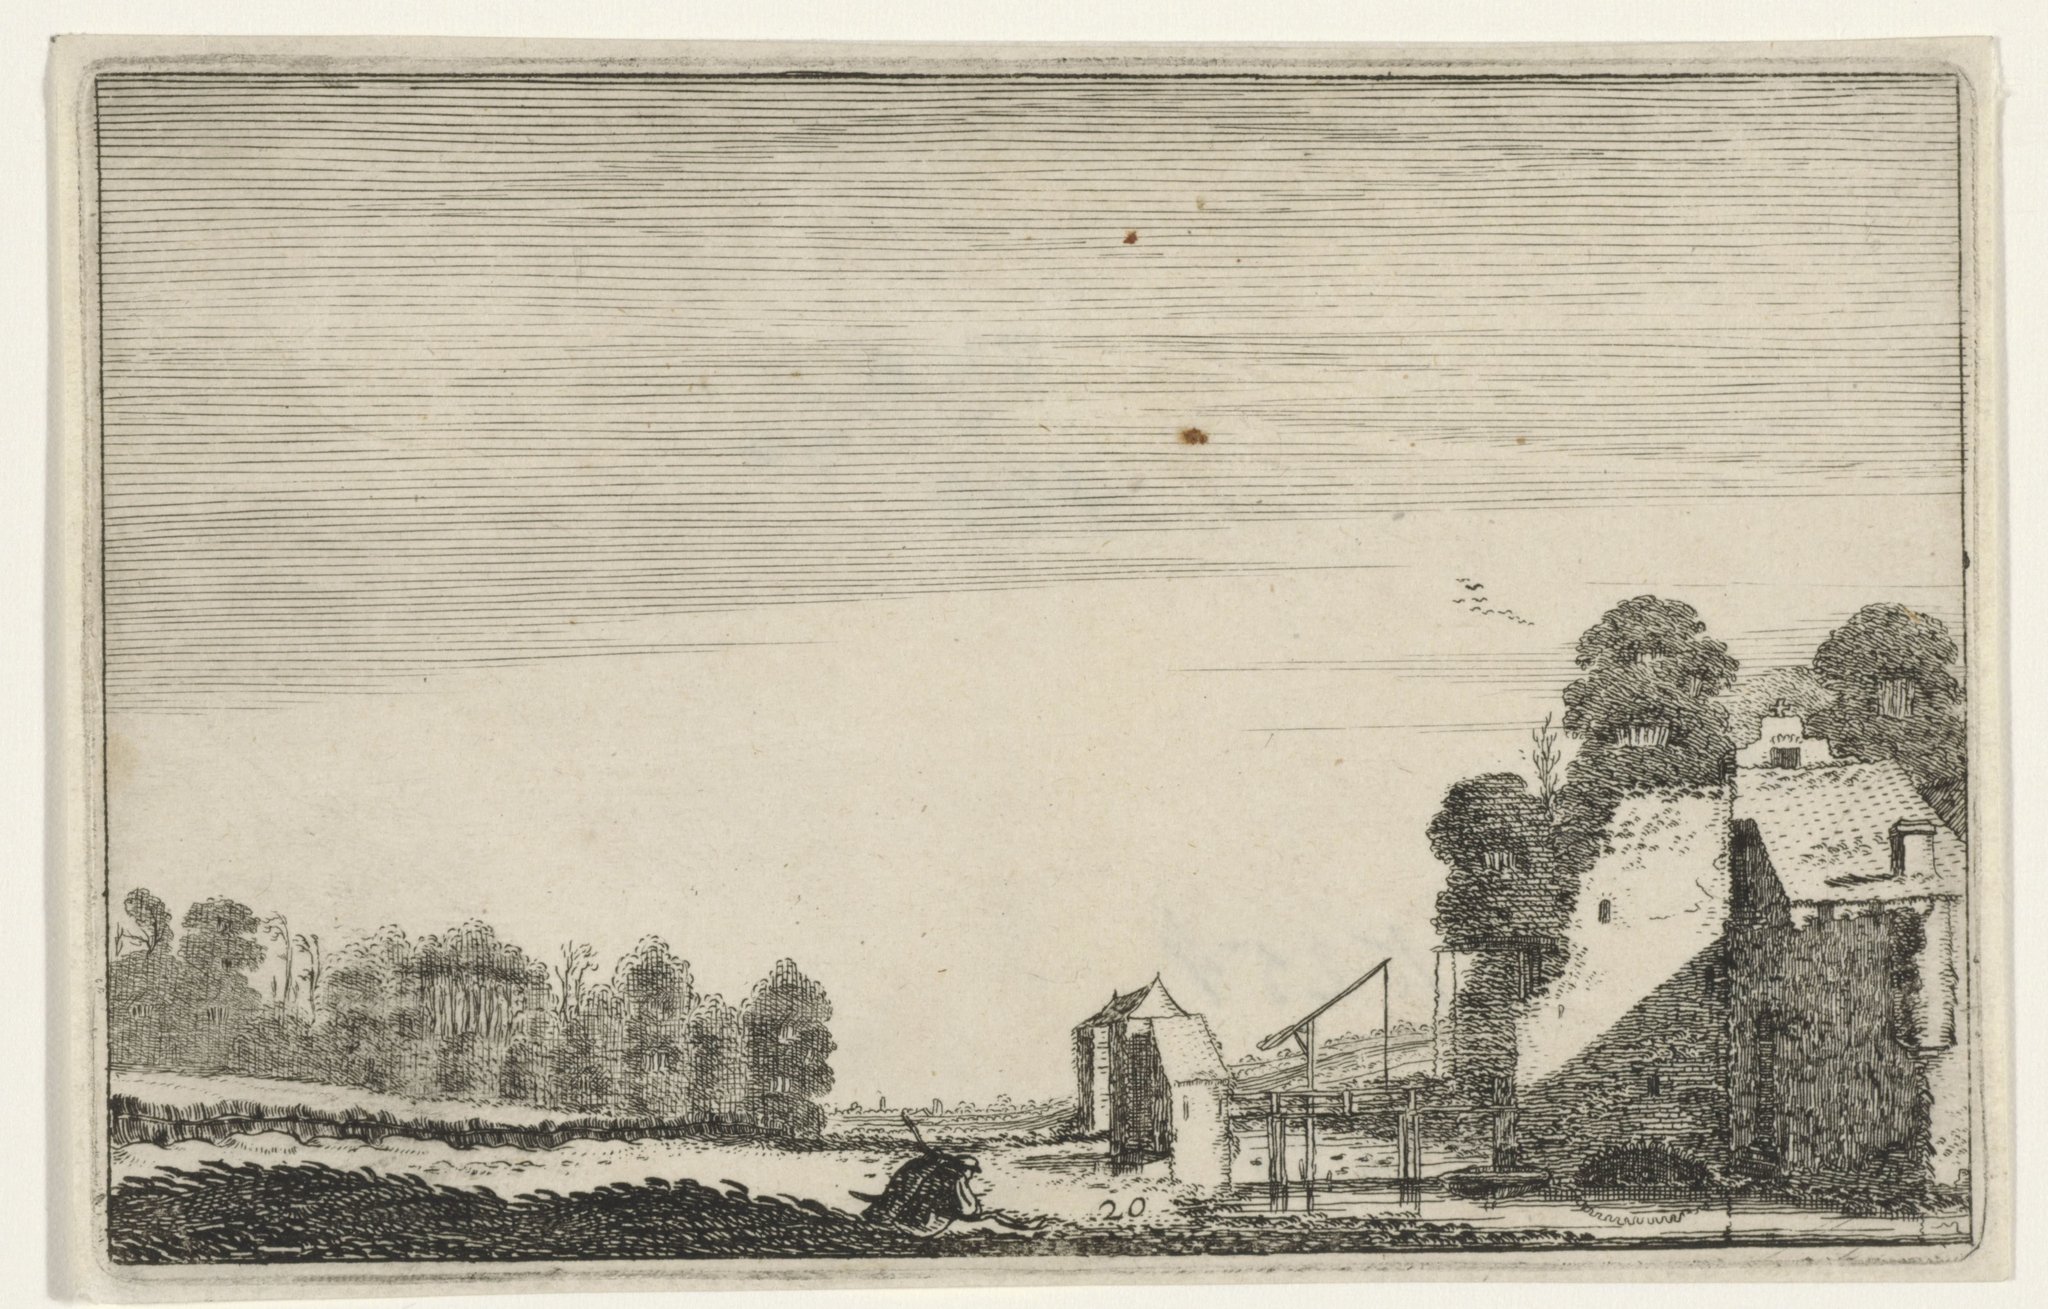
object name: print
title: Ruïnes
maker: jan van de velde (ii)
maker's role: draughtsman, painter, print maker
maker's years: 1593-1641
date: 1616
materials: paper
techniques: engraving, etching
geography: northern netherlands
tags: bridges by construction, landscape with bridge, viaduct or aqueduct, landscape with ruins, ruin of a dwelling, house, castle, etc.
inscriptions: collector's mark: Lugt 964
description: Ruïne van een huis met een houten brug in een landschap. Twintigste prent uit een serie van twintig.